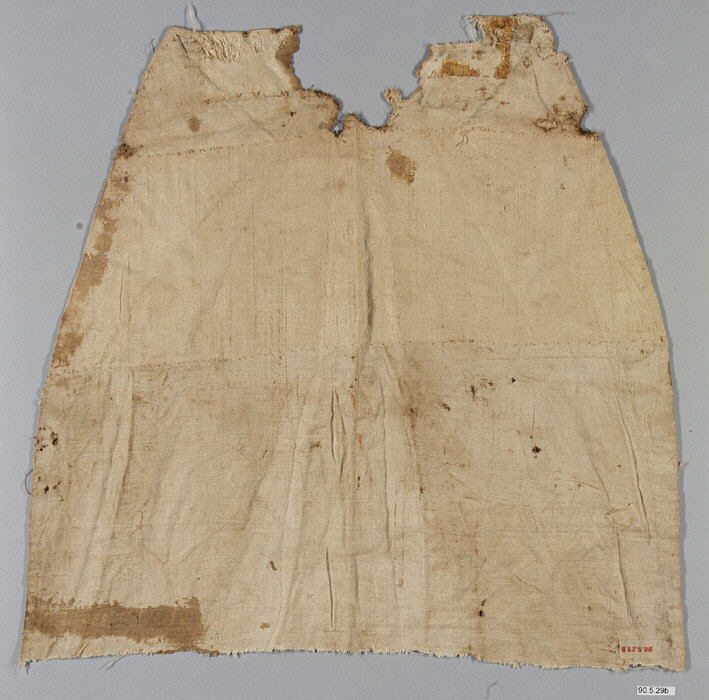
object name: textile fragment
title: Fragment of a Tunic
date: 501-600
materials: linen